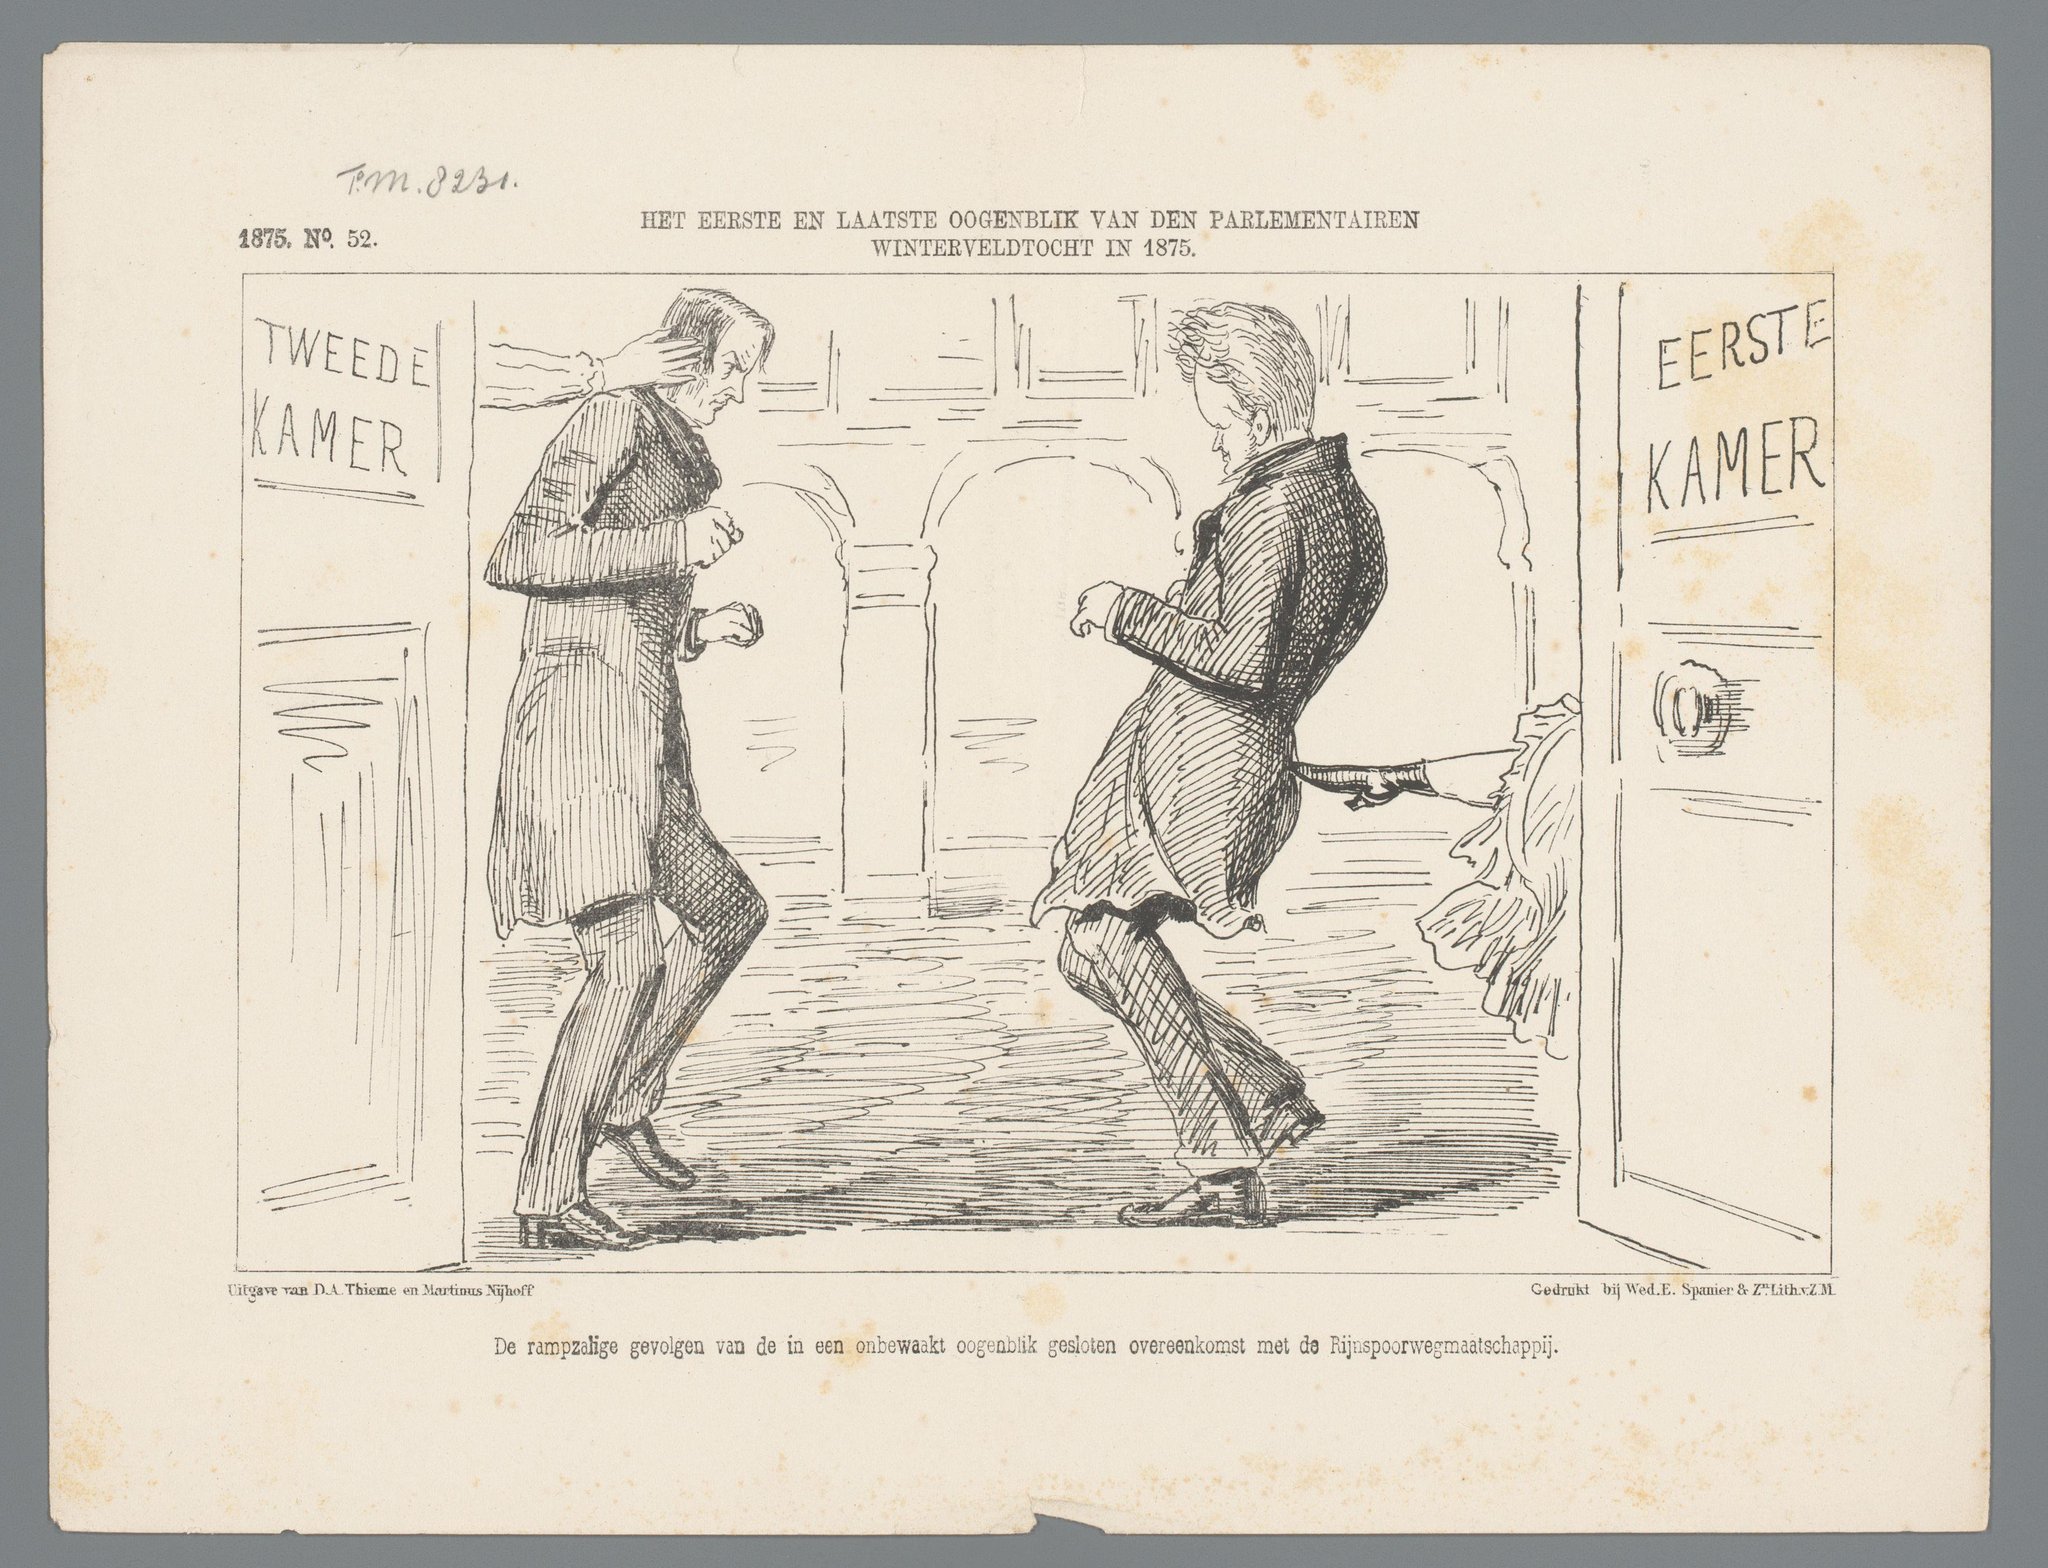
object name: print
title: Het eerste en laatste oogenblik van den parlementairen winterveldtocht in 1875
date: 1875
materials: paper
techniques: lithograph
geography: netherlands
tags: politician, rotterdam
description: Spotprent op de discussie over de aansluiting van de Rhijnspoorweg te Rotterdam, 1875. Plaat verschenen bij het weekblad De Nederlandsche Spectator, nr. 52, 1875.